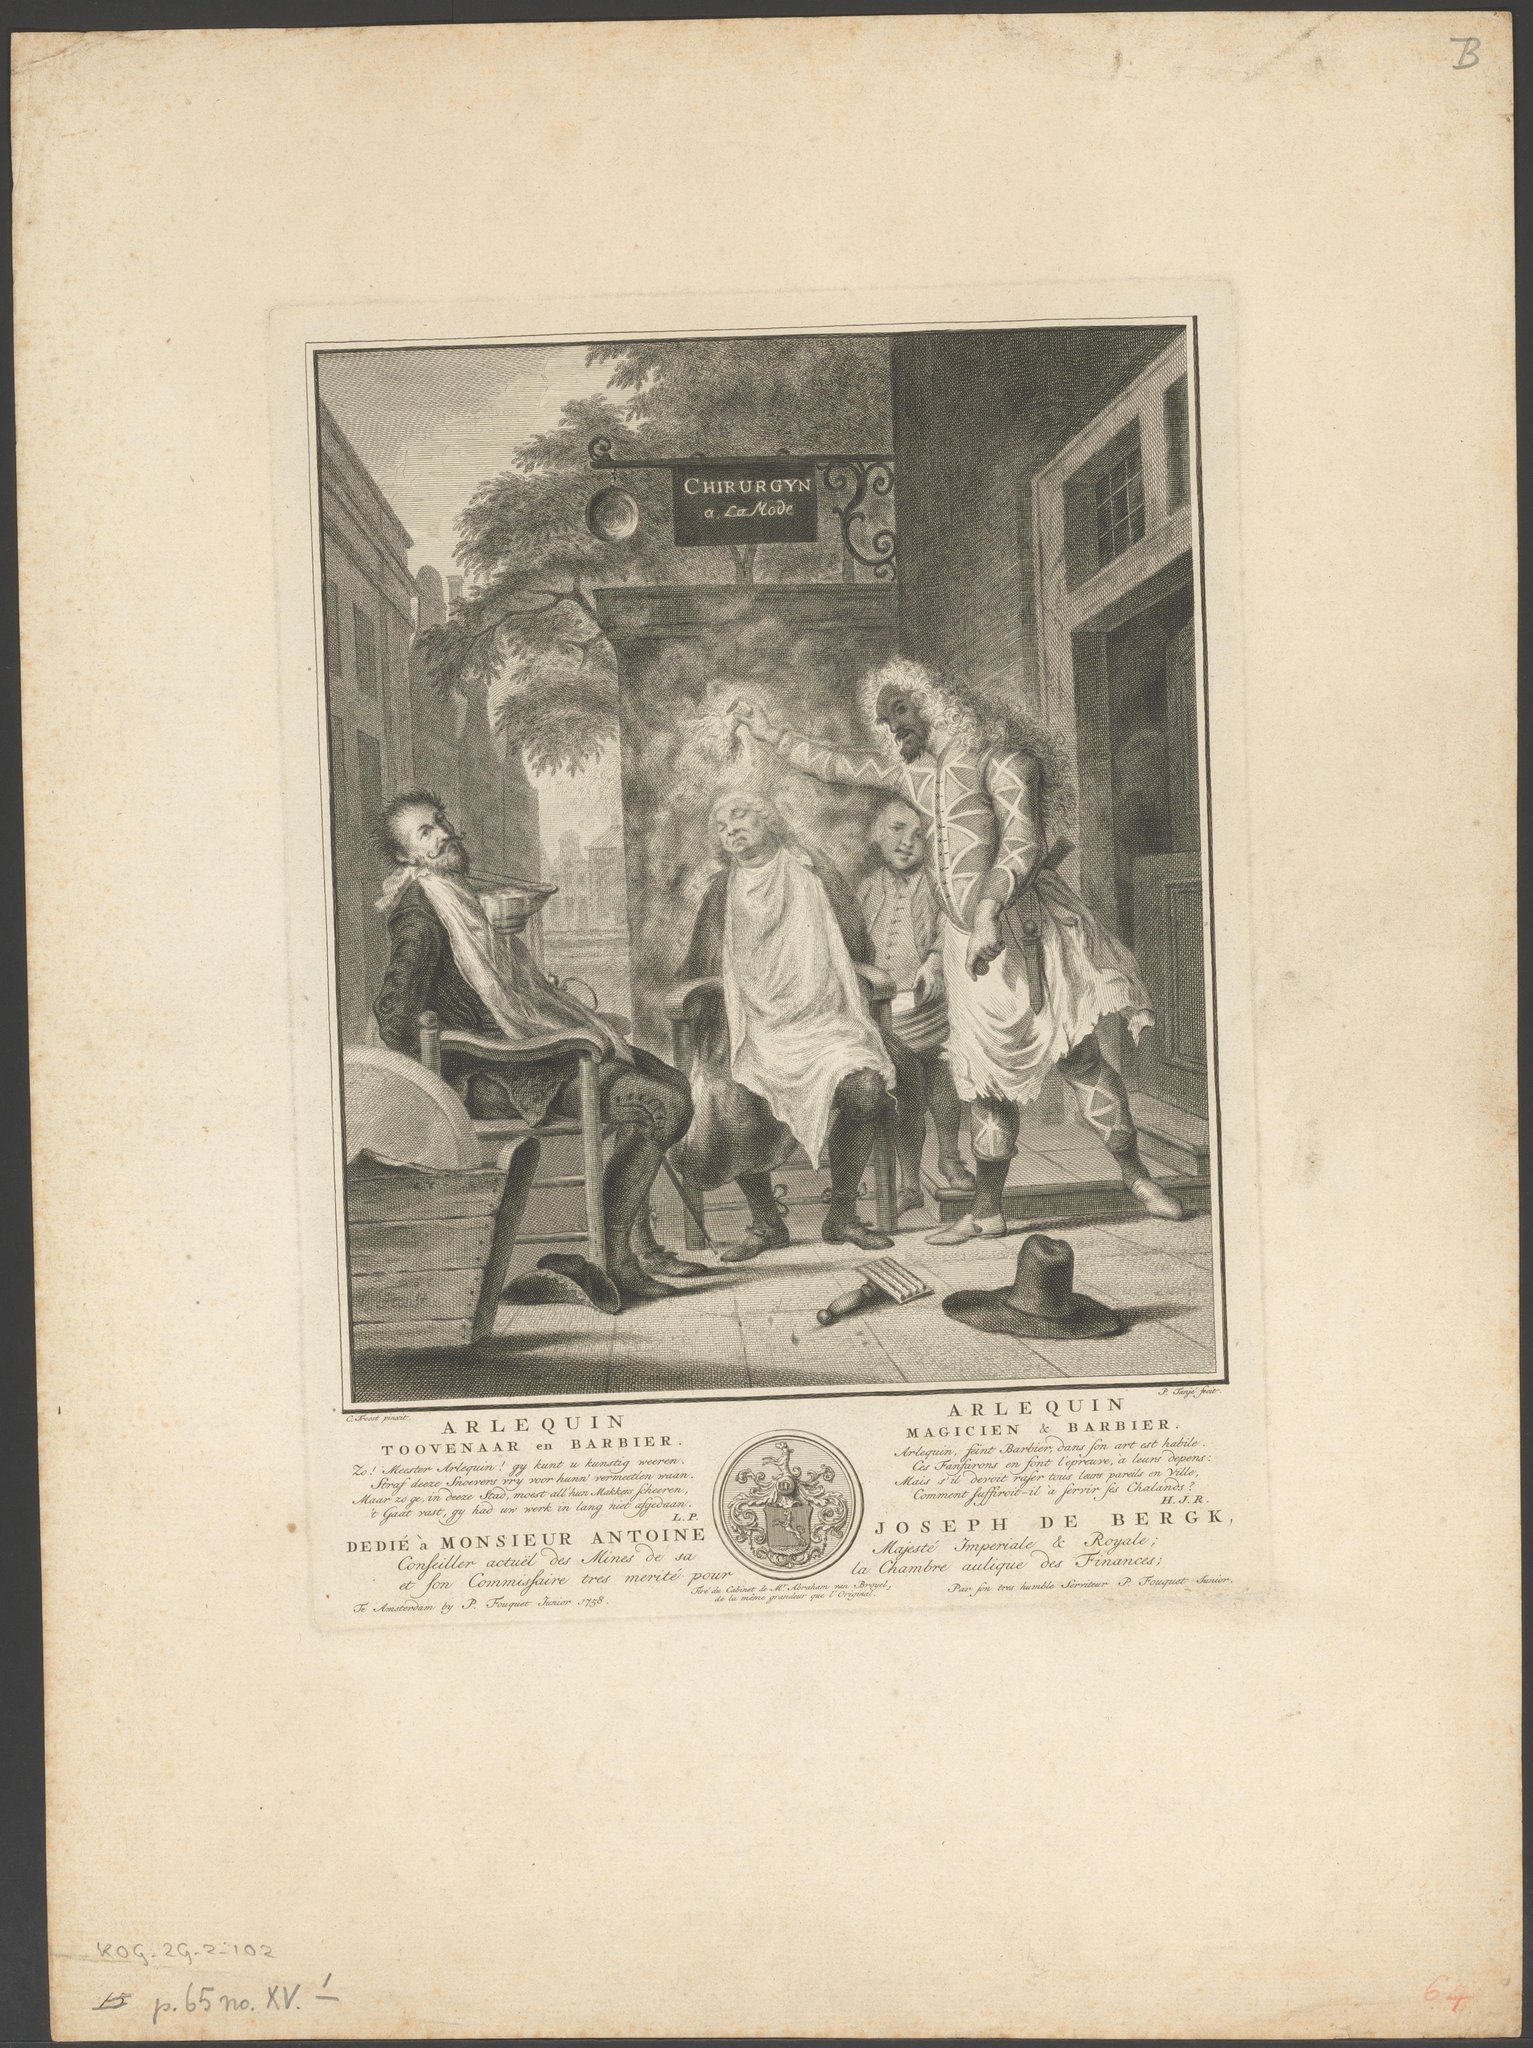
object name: print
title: Arlequin toovenaar en barbier / Arlequin magicien & barbier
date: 1758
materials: paper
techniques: engraving, etching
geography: amsterdam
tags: types in 'commedia dell'arte': harlequin, 'commedia dell'arte', barber, barbershop, comedy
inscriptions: collector's mark: Lugt 2488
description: Belloardo en Capitano worden door de als barbier verklede Arlequin hardhandig geschoren en bepoedert met natgemaakt meel. Zijn knechtje Pierot houdt de bak met meel op. Arlequin heeft onder zijn linkerarm een knuppel verborgen waarmee hij zijn rivalen Belloardo en Capitano tot slot zal bewerken. Onderaan in de marge een vierregelig vers in het Nederlands en het Frans. Scène uit de klucht Arlequin, tovenaar, en barbier, van Willem van der Hoeven.